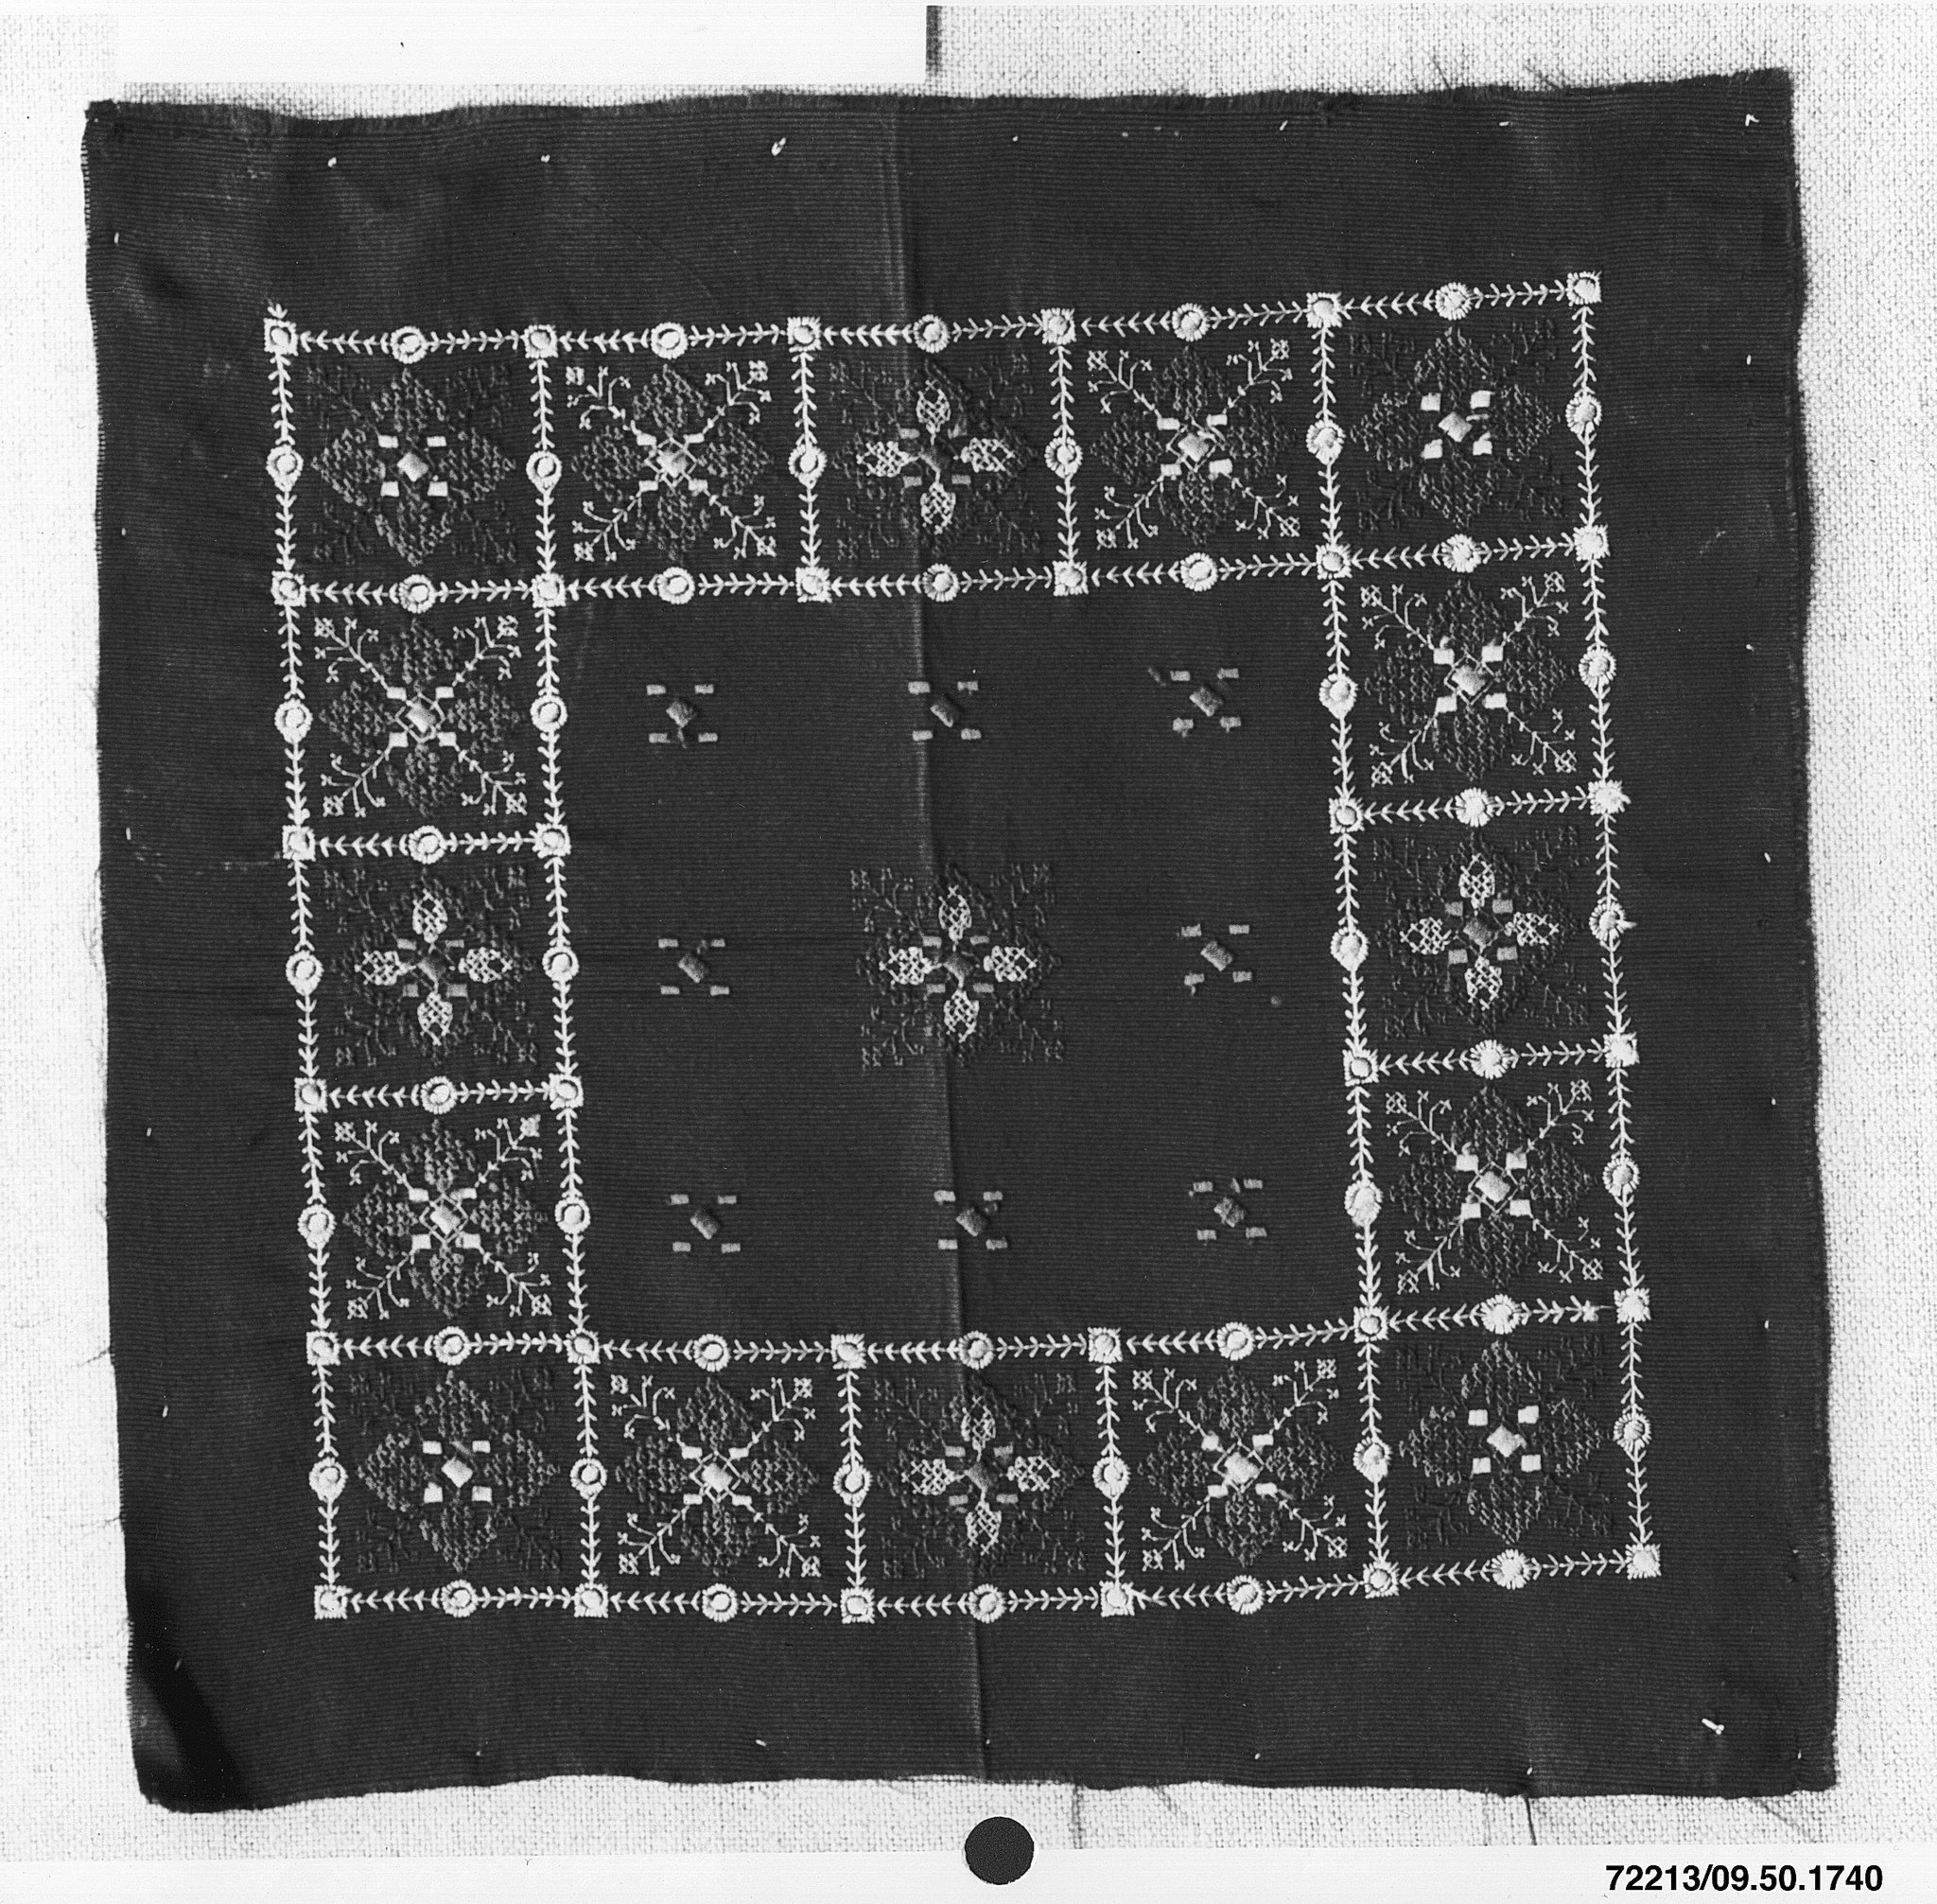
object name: fragment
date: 1801-1900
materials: silk